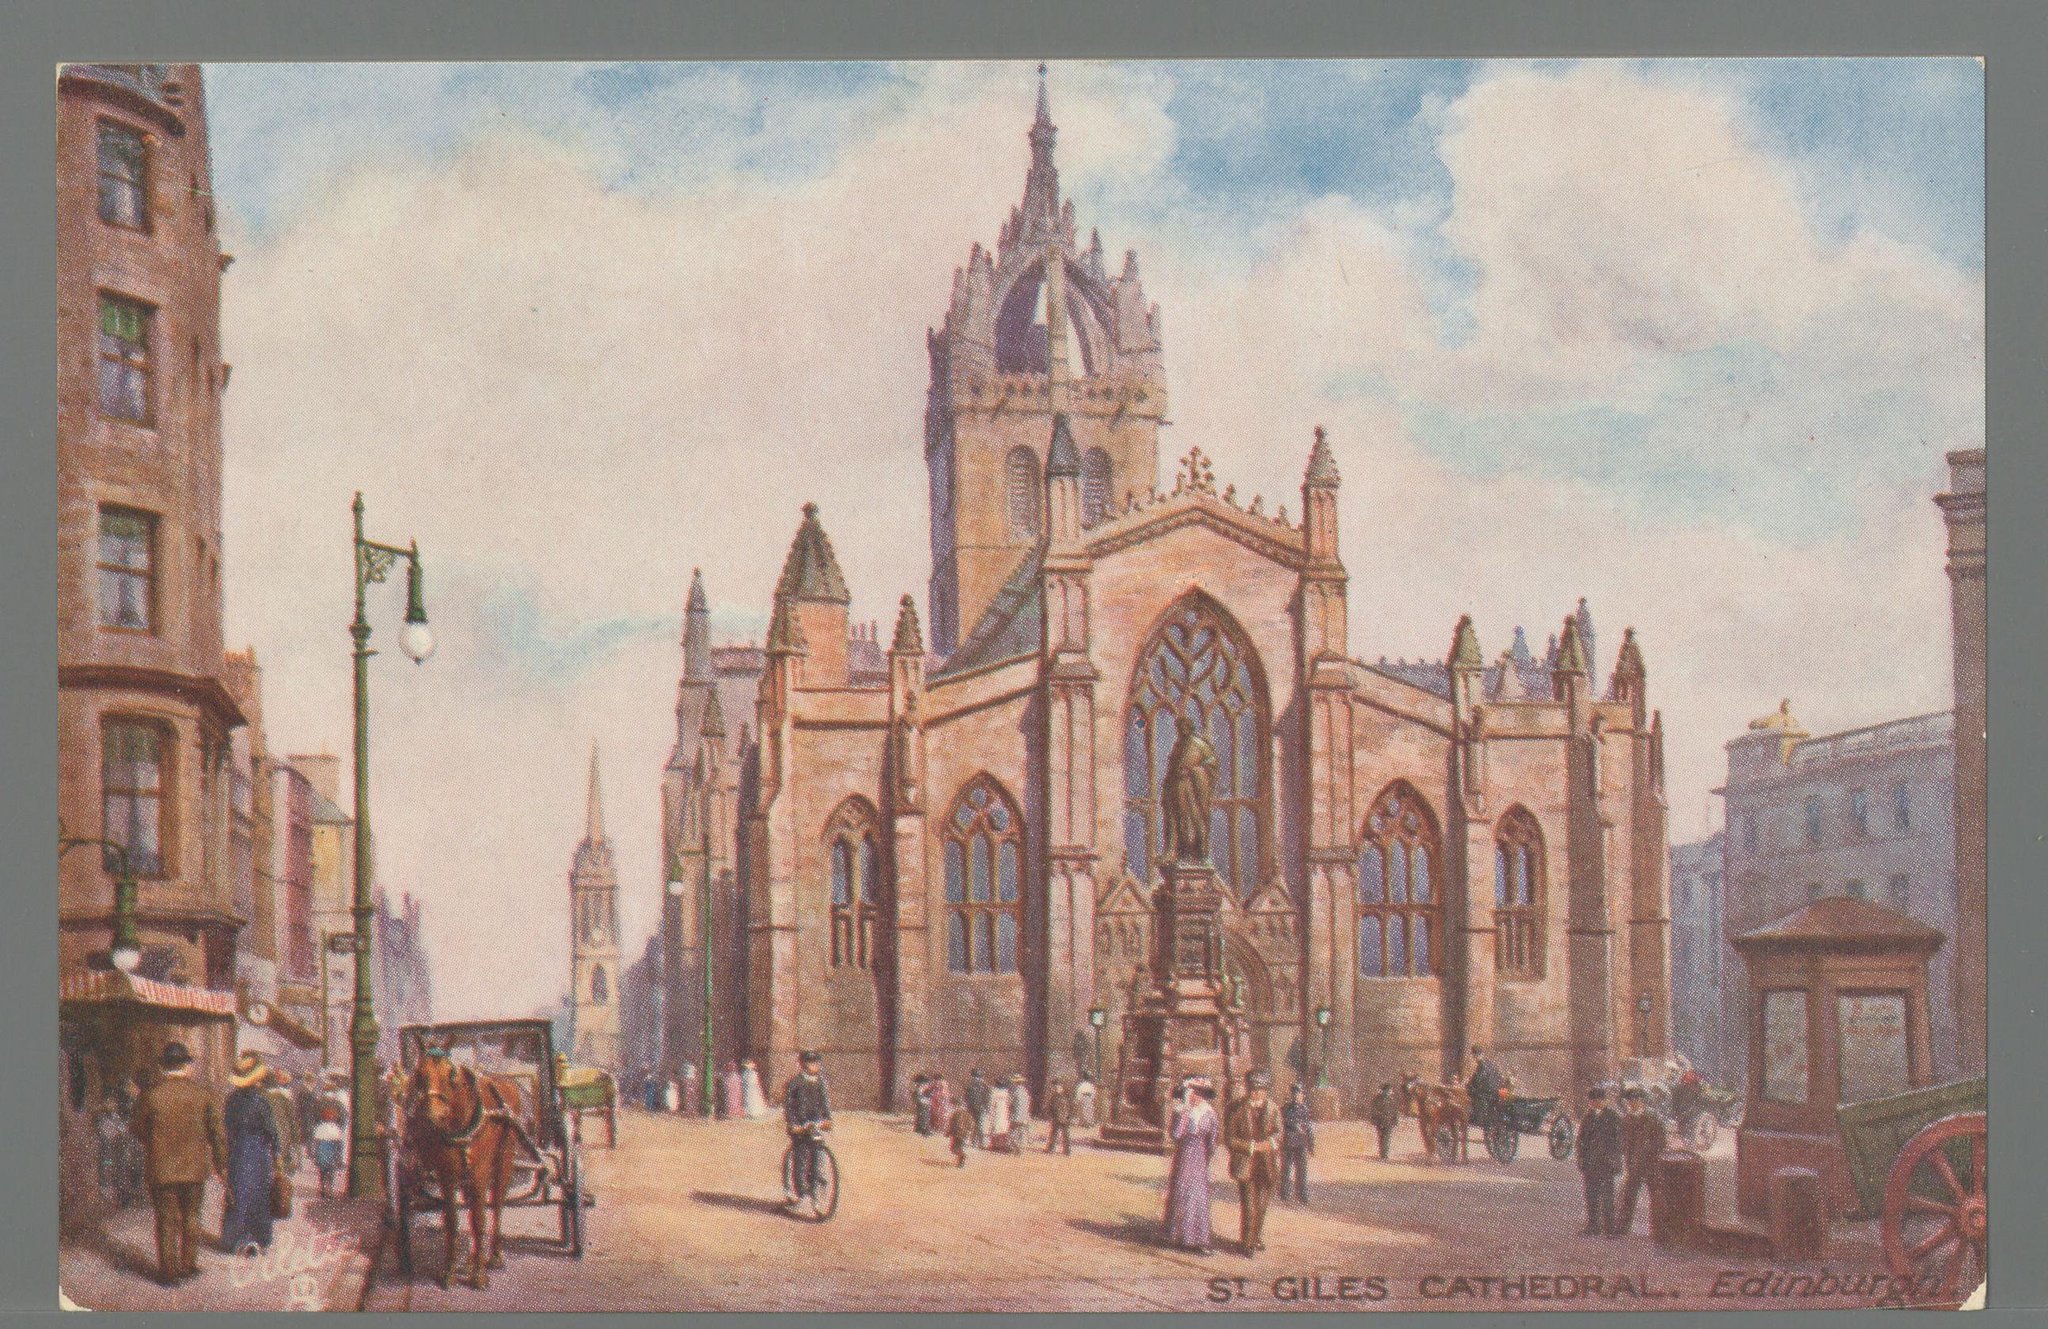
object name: photomechanical print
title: Edinburgh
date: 1902-1905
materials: cardboard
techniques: color autotype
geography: london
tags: church (exterior), street